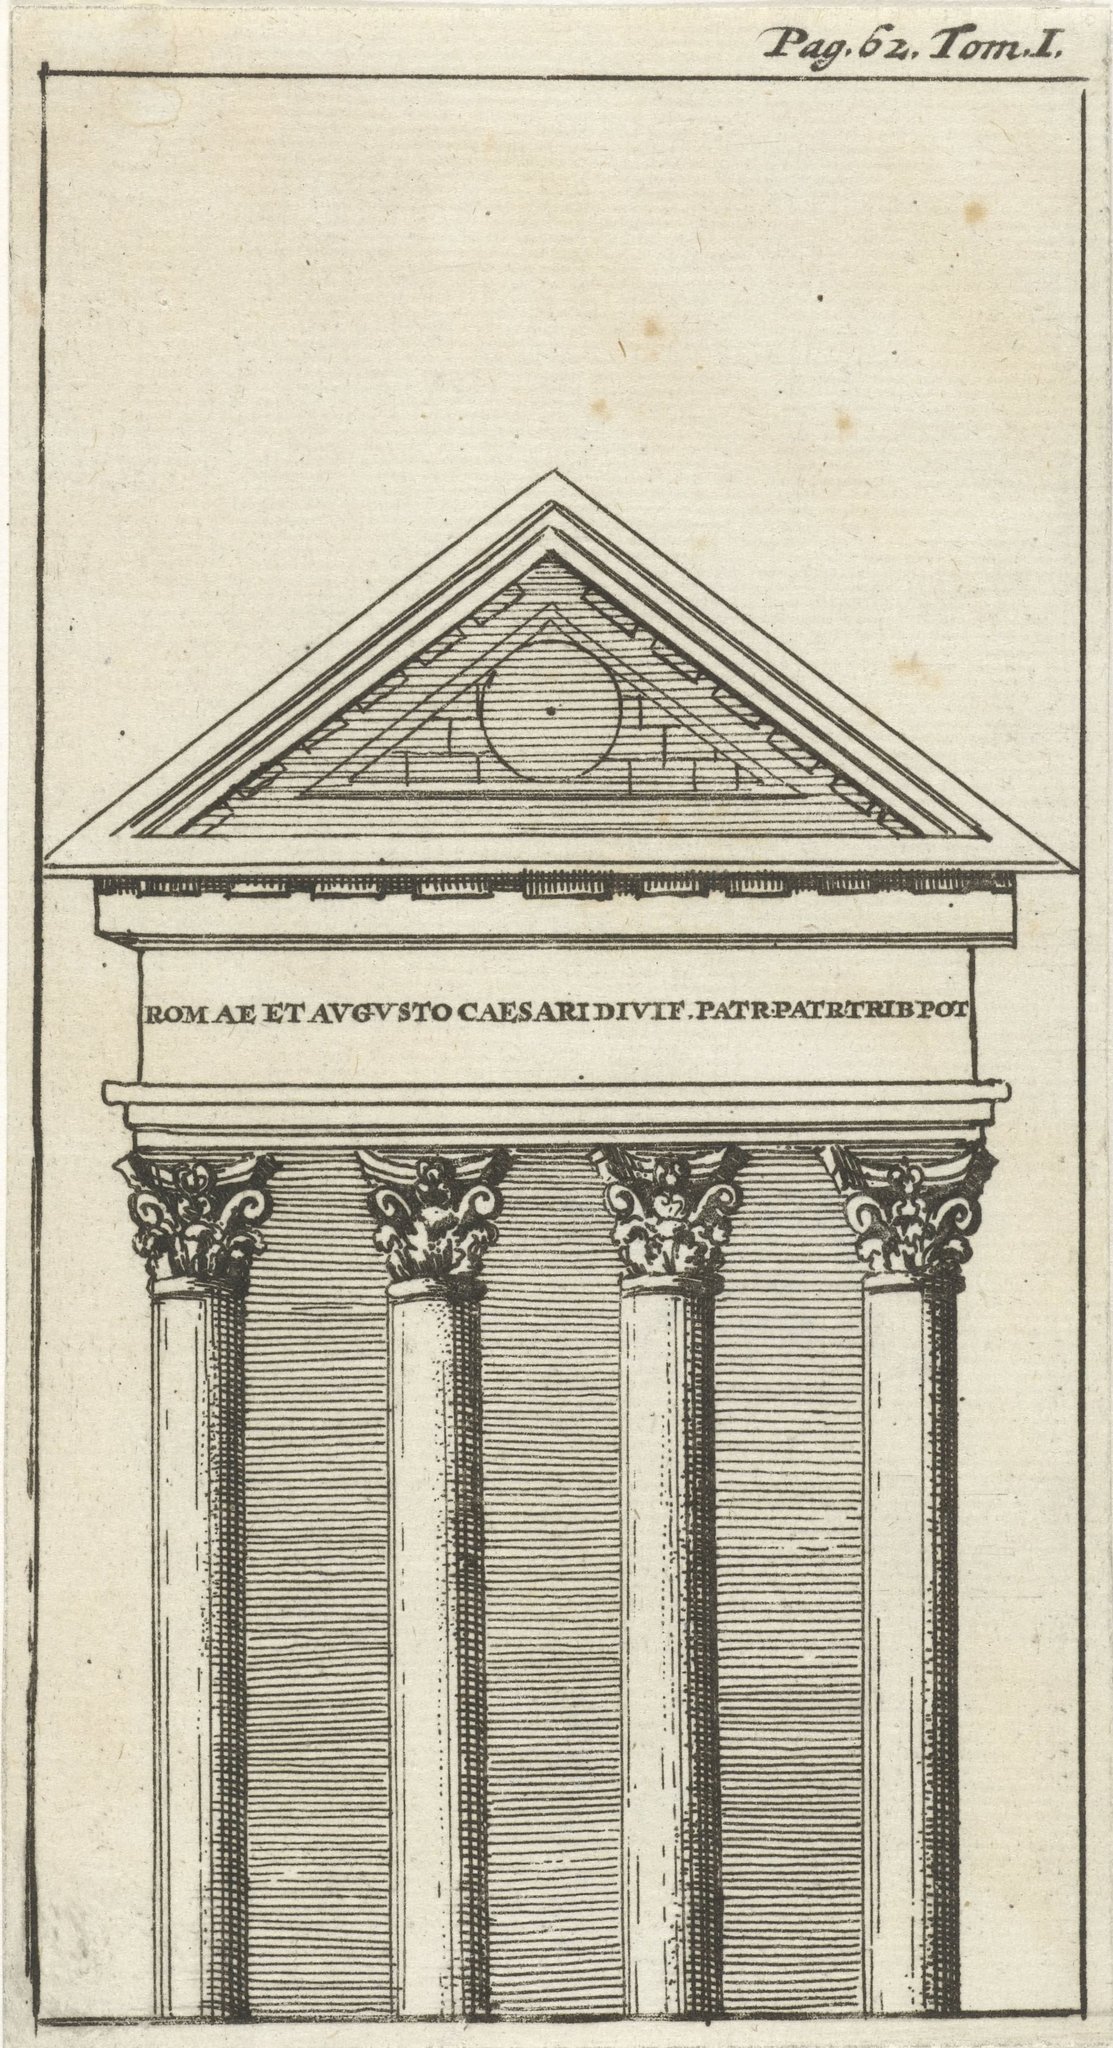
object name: book illustration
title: Romeinse tempel bij Pula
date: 1679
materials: paper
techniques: etching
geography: amsterdam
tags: temple, shrine ~ roman religion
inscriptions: collector's mark: Lugt 2228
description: Illustratie opgenomen in: Spon, Jacob. Voyage d'Italie, de Dalmatie, de Grece, et du Levant, 2 delen. Amsterdam: Hendrick en Dirk Boom, 1679, dl. I, p. 62.